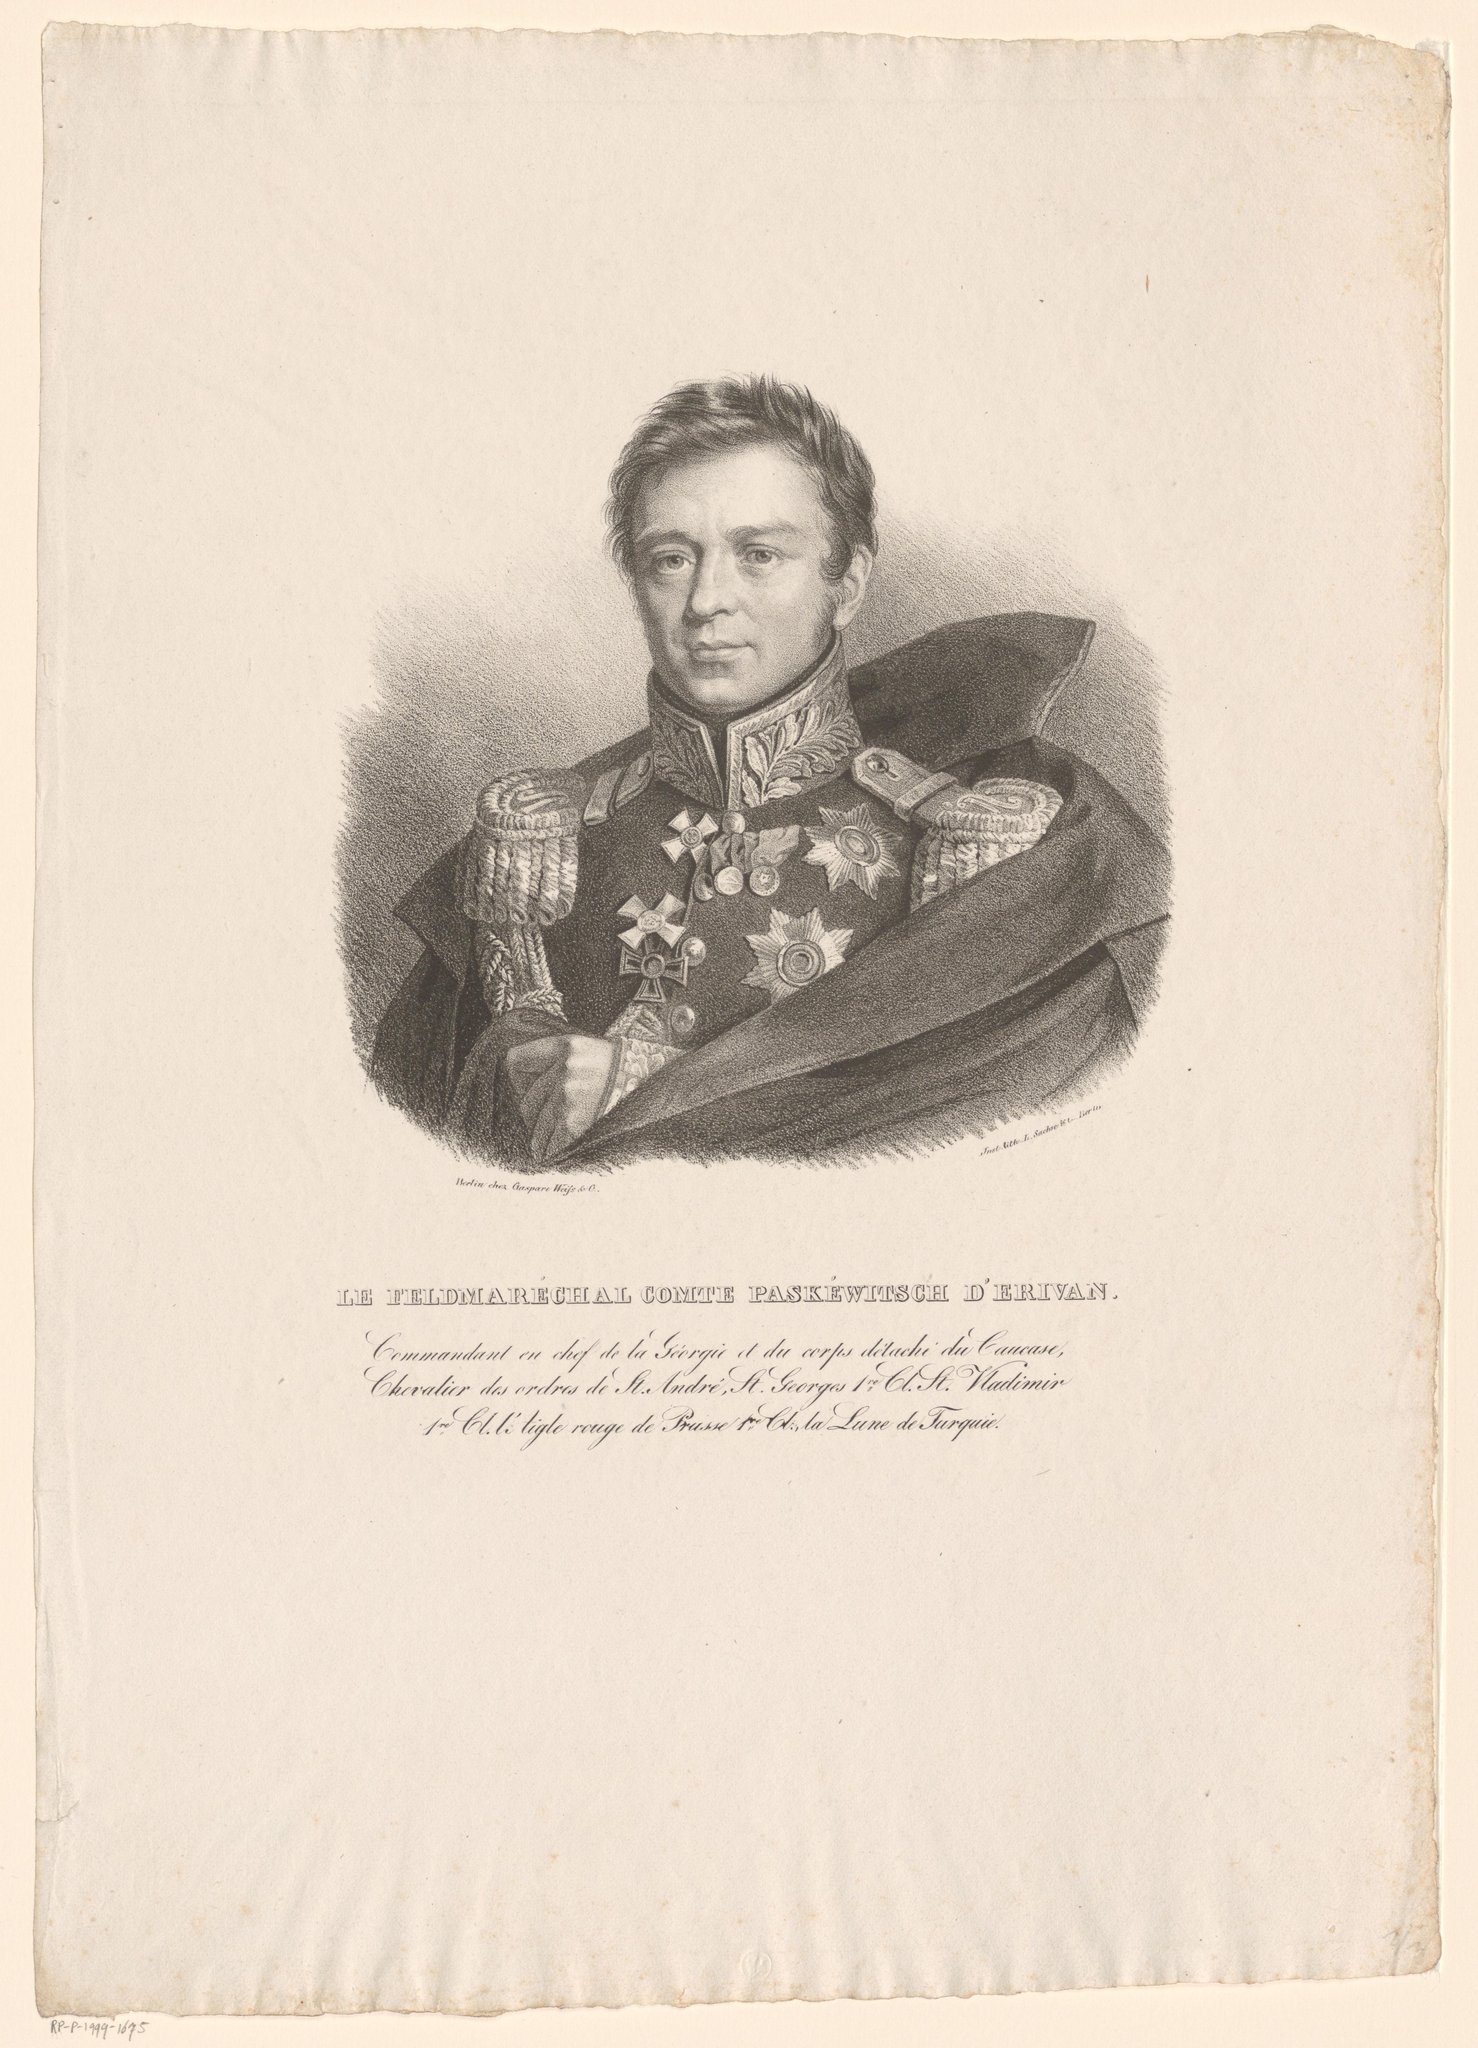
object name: print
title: Portret van Ivan Paskevitsj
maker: Anonymous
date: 1832-1854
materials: paper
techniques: lithograph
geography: berlin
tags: earl, politician, commander-in-chief, general, marshal, adult man, historical persons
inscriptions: check stamp: ‘GIW’, collector's mark: Lugt 2228, collector's mark: Lugt 2760, inscription: ‘Russen portr. mappe 56027/ Pas Kiewitsch/ LB XXII 404516’